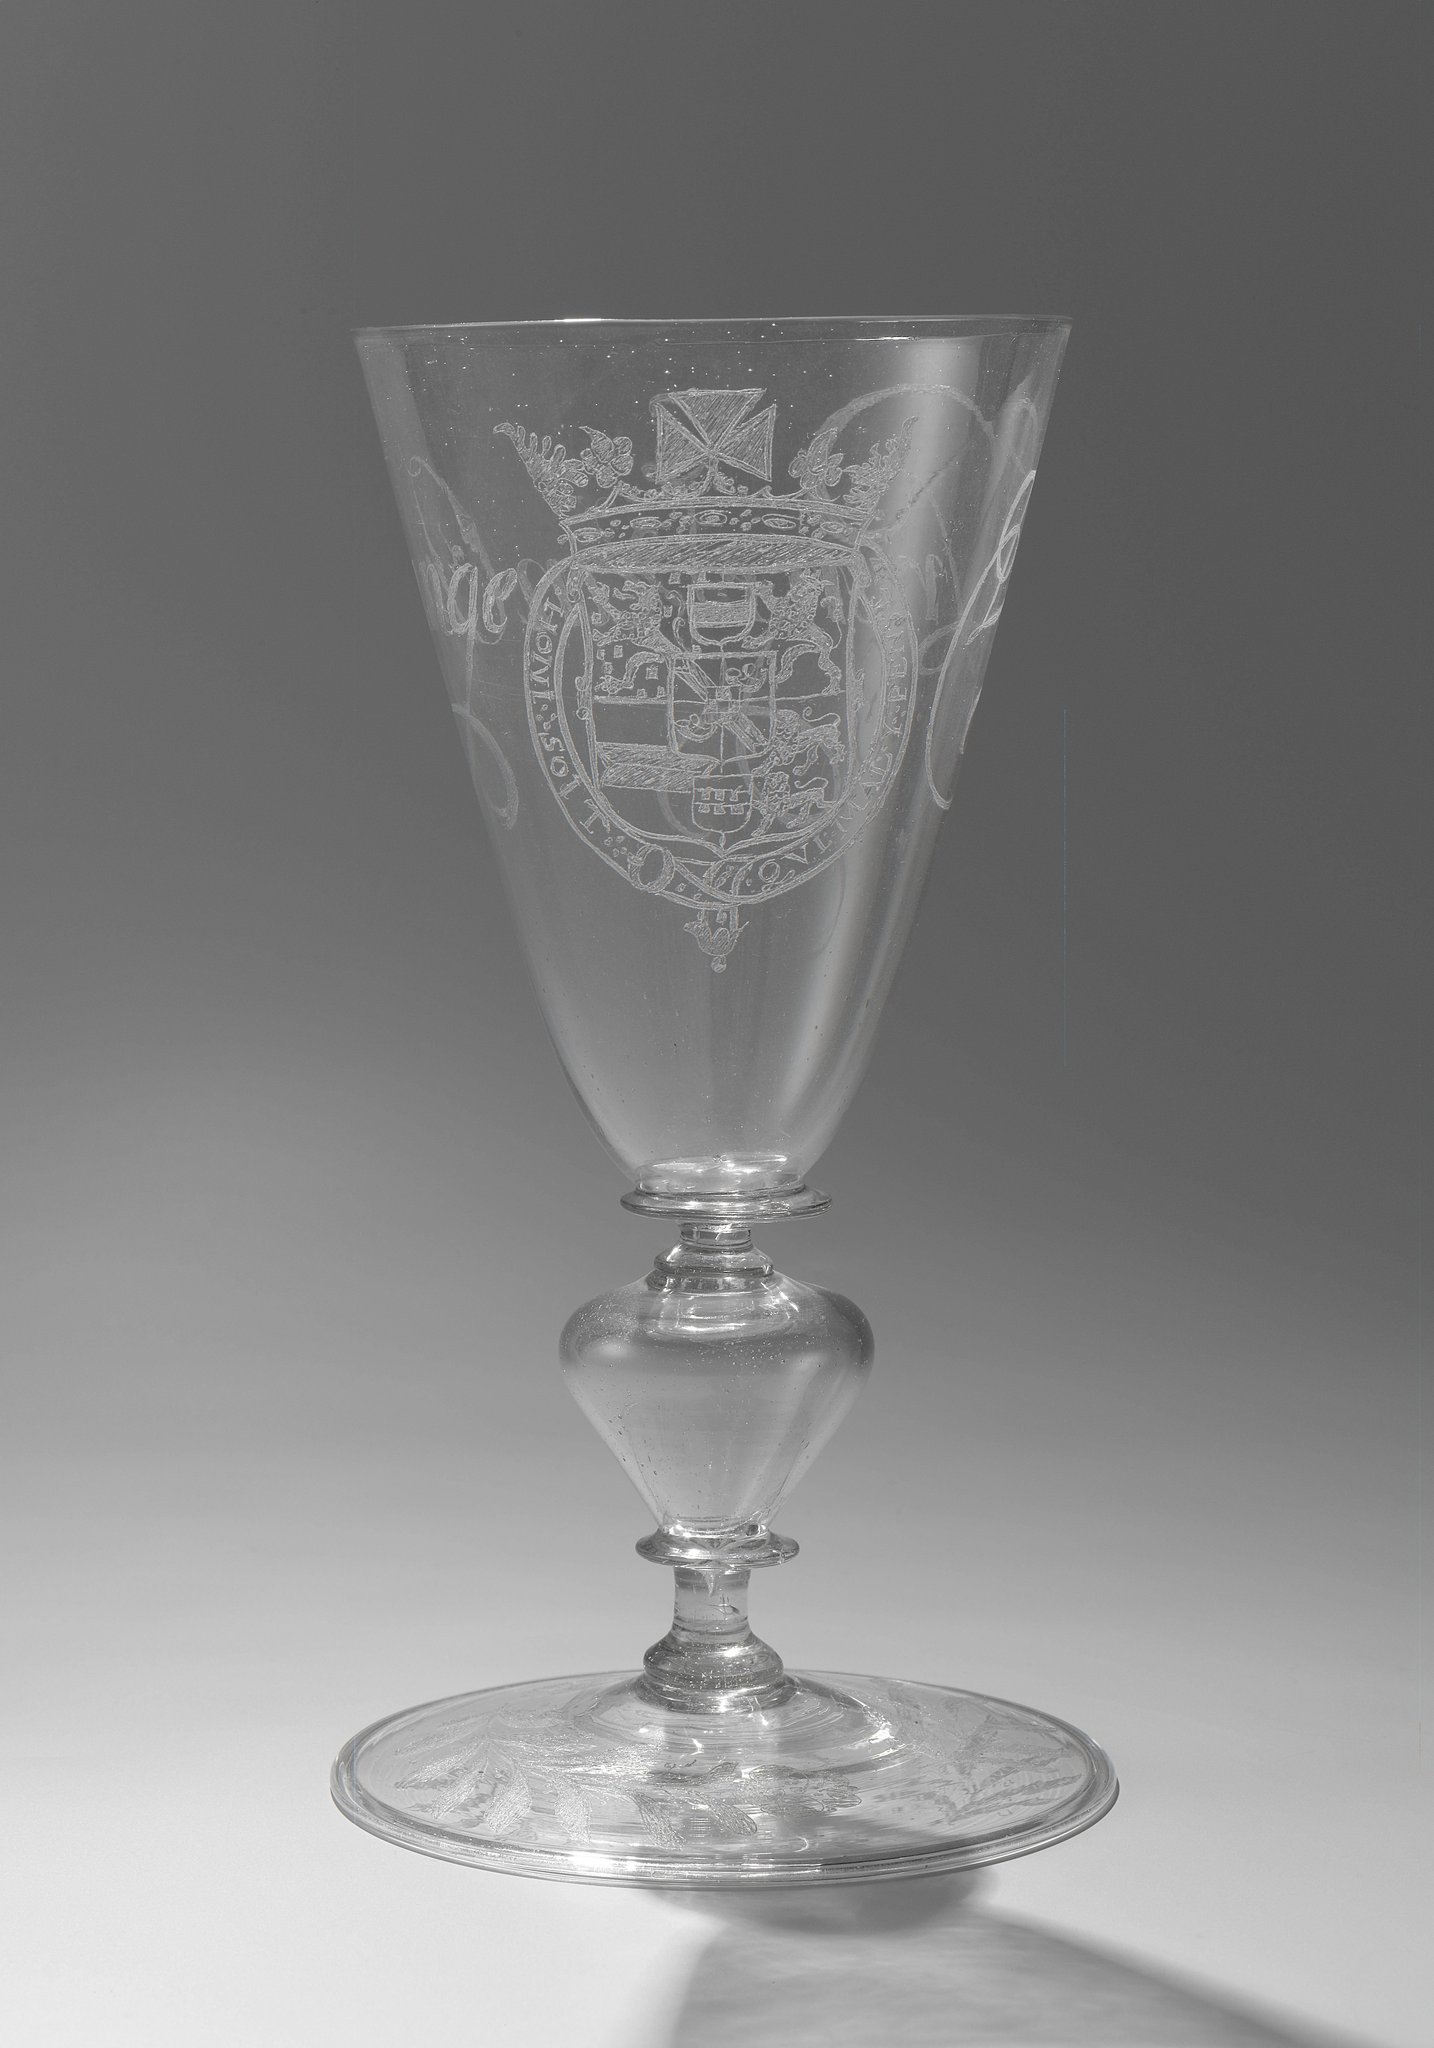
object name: goblet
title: Kelkglas met het wapen van Willem III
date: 1675-1700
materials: glass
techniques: diamond point engraving, façon de venise, glassblowing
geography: rotterdam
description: Orange souvenirs. William III's popularity, and later also that of his wife Mary, gave rise to a wide variety of objects sporting their pictures: medallions, glasses, tiles, cutlery and Delftware pottery.